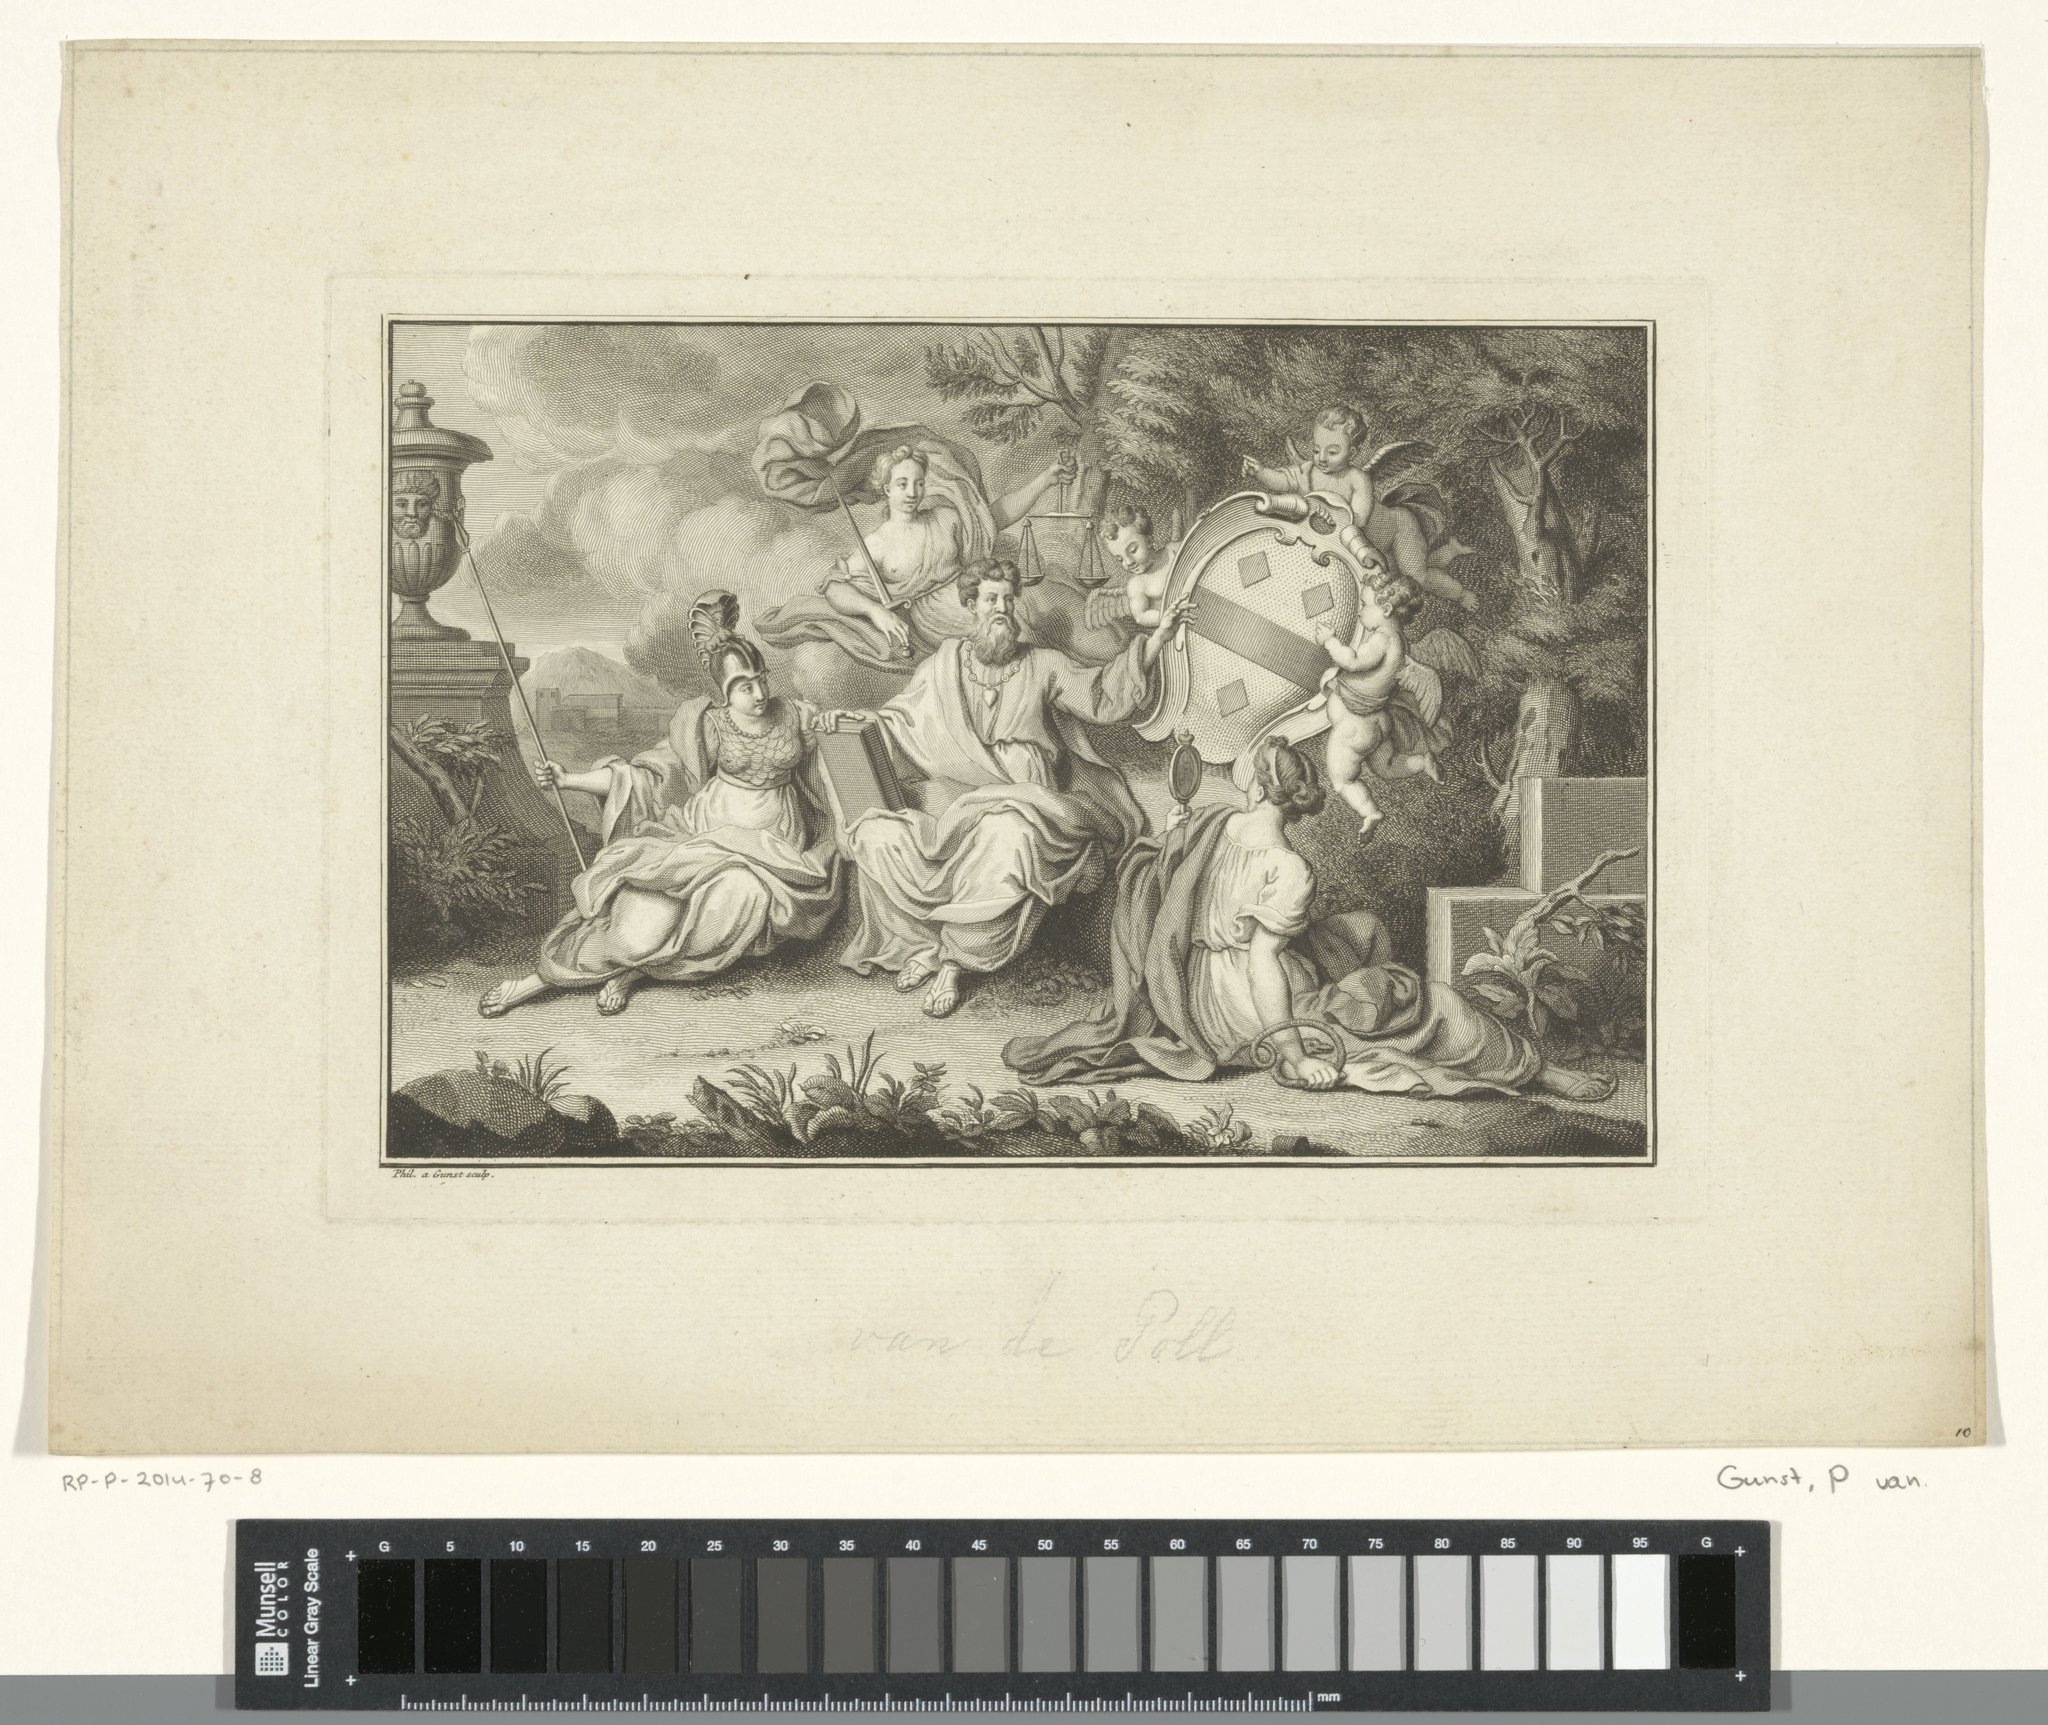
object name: print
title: Familiewapen Van de Poll in allegorische setting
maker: philip van gunst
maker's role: print maker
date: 1685-1732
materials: paper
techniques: etching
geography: amsterdam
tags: minerva as patroness, justice, 'justitia'; 'giustitia divina' (ripa) ~ one of the four cardinal virtues, prudence, 'prudentia'; 'prudenza' (ripa) ~ one of the four cardinal virtues, armorial bearing, heraldry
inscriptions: collector's mark: Lugt 2228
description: Minerva, Justitia, Prudentia, en een oude man met een boek, bij het wapen van de familie Van de Poll.